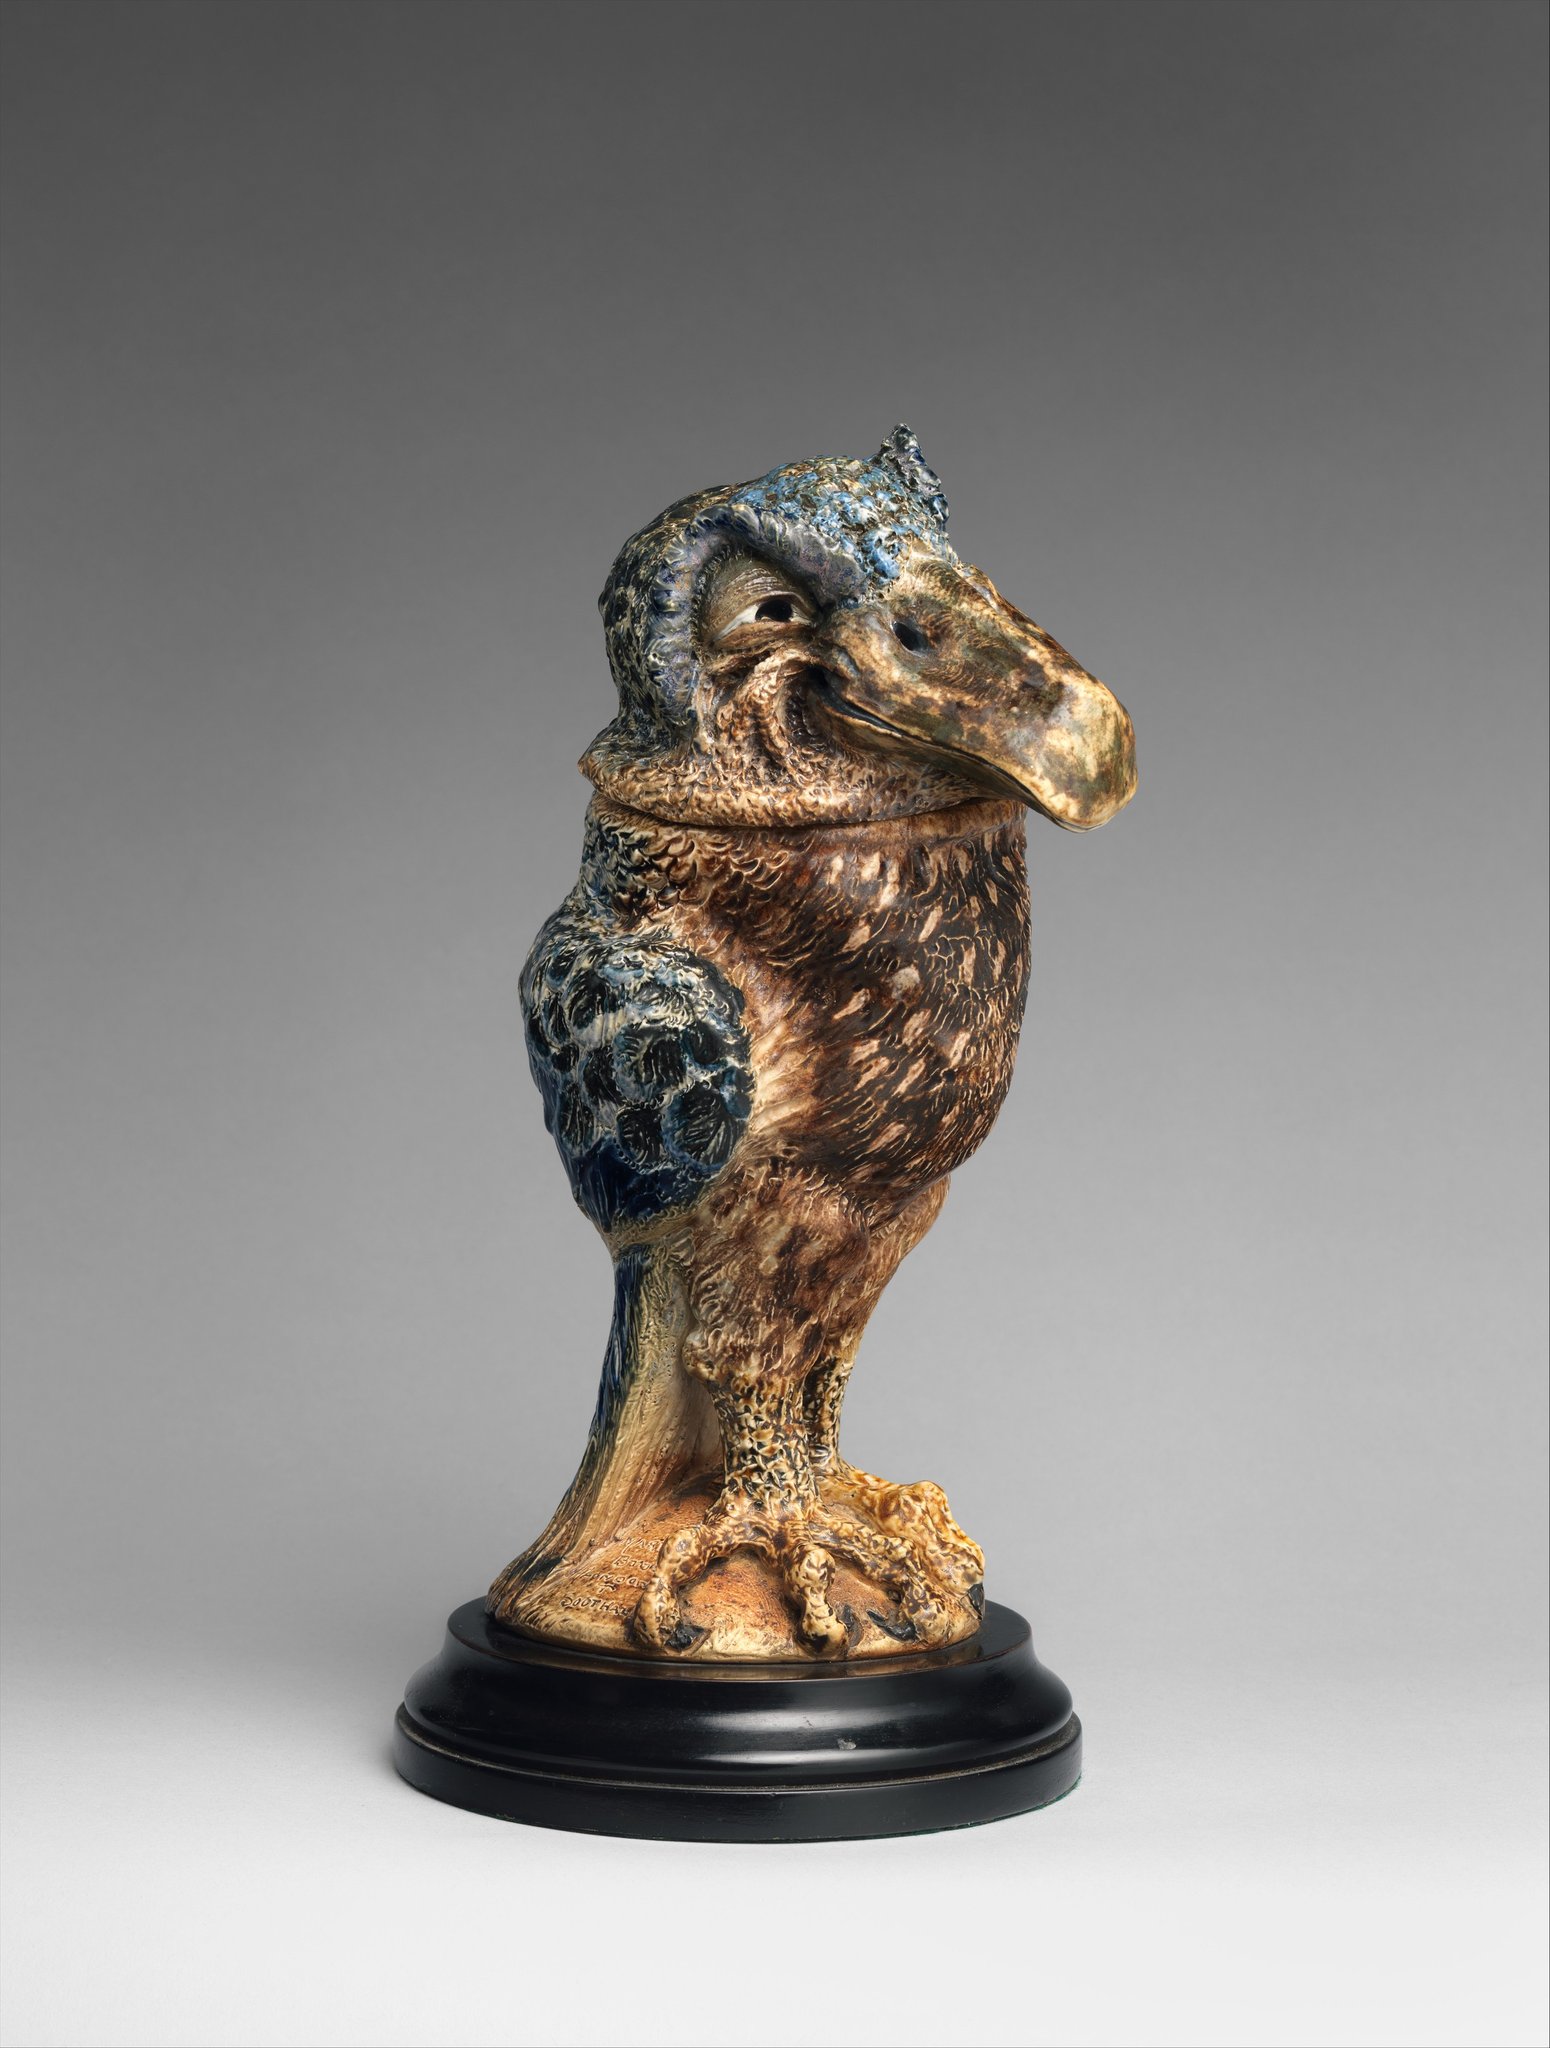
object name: figure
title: Jar in the form of a bird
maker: r. w. martin and brothers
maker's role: maker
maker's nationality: british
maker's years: 1873-1915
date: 1888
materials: stoneware, wood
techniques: glazing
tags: birds